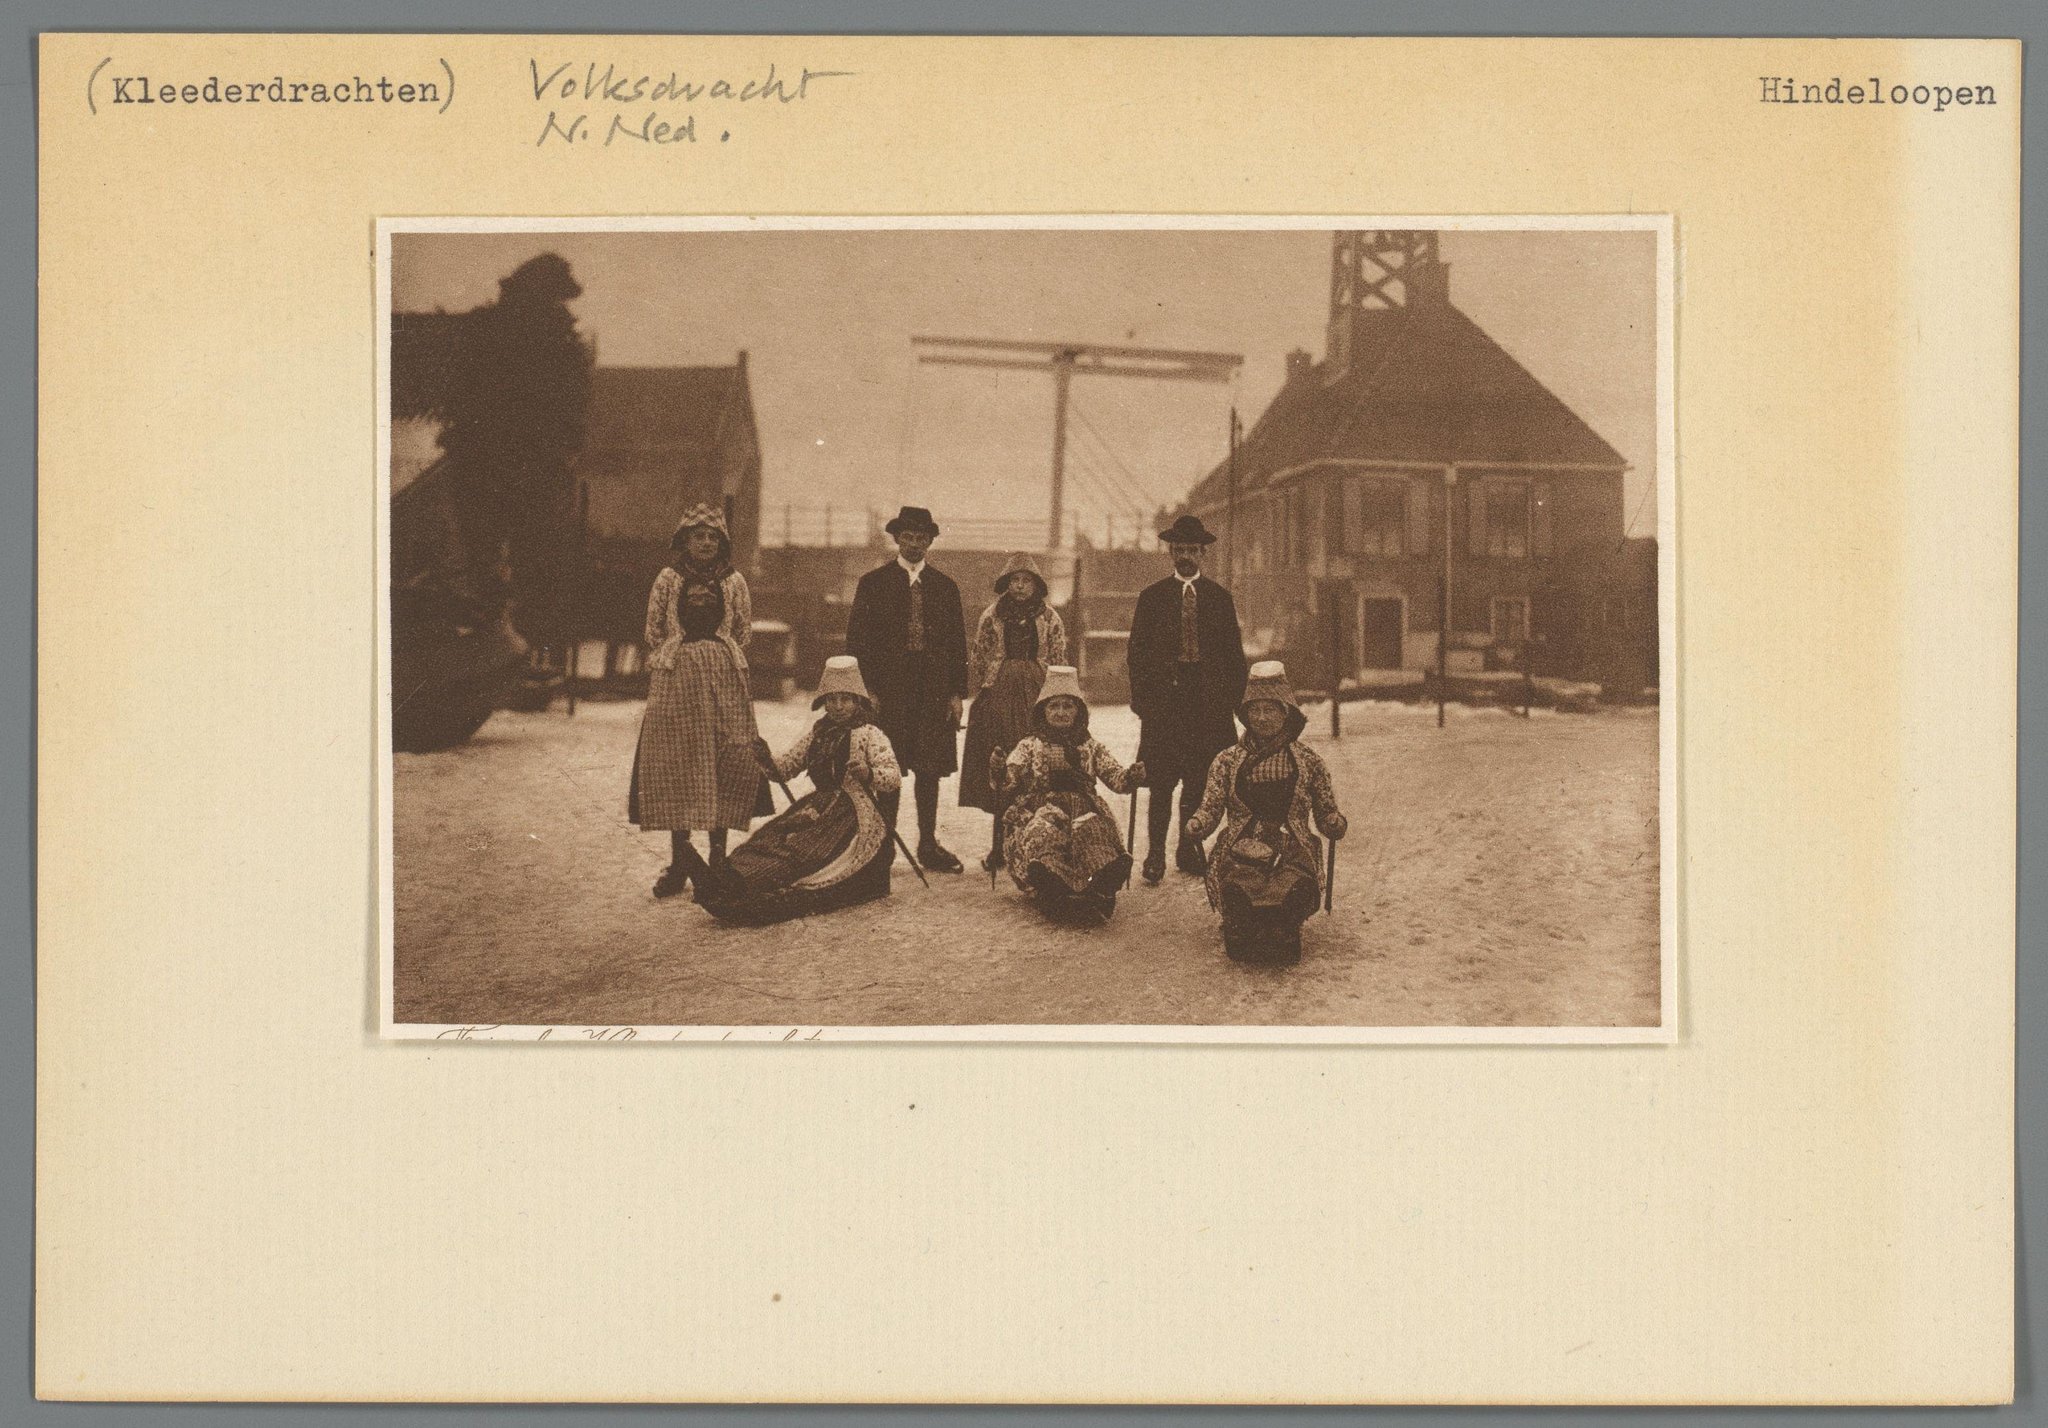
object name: photomechanical print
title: Hindeloopen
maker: Anonymous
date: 1905-1920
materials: paper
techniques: rotogravure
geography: hindeloopen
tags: historical persons, sleigh, sledge (non-sport), skates (winter sports), folk costume, regional costume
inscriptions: inscription: ‘Volksdracht/ N.Ned.’, number: ‘23.757’, number: ‘- 527028’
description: Op de voorgrond drie vrouwen op een prikslee.